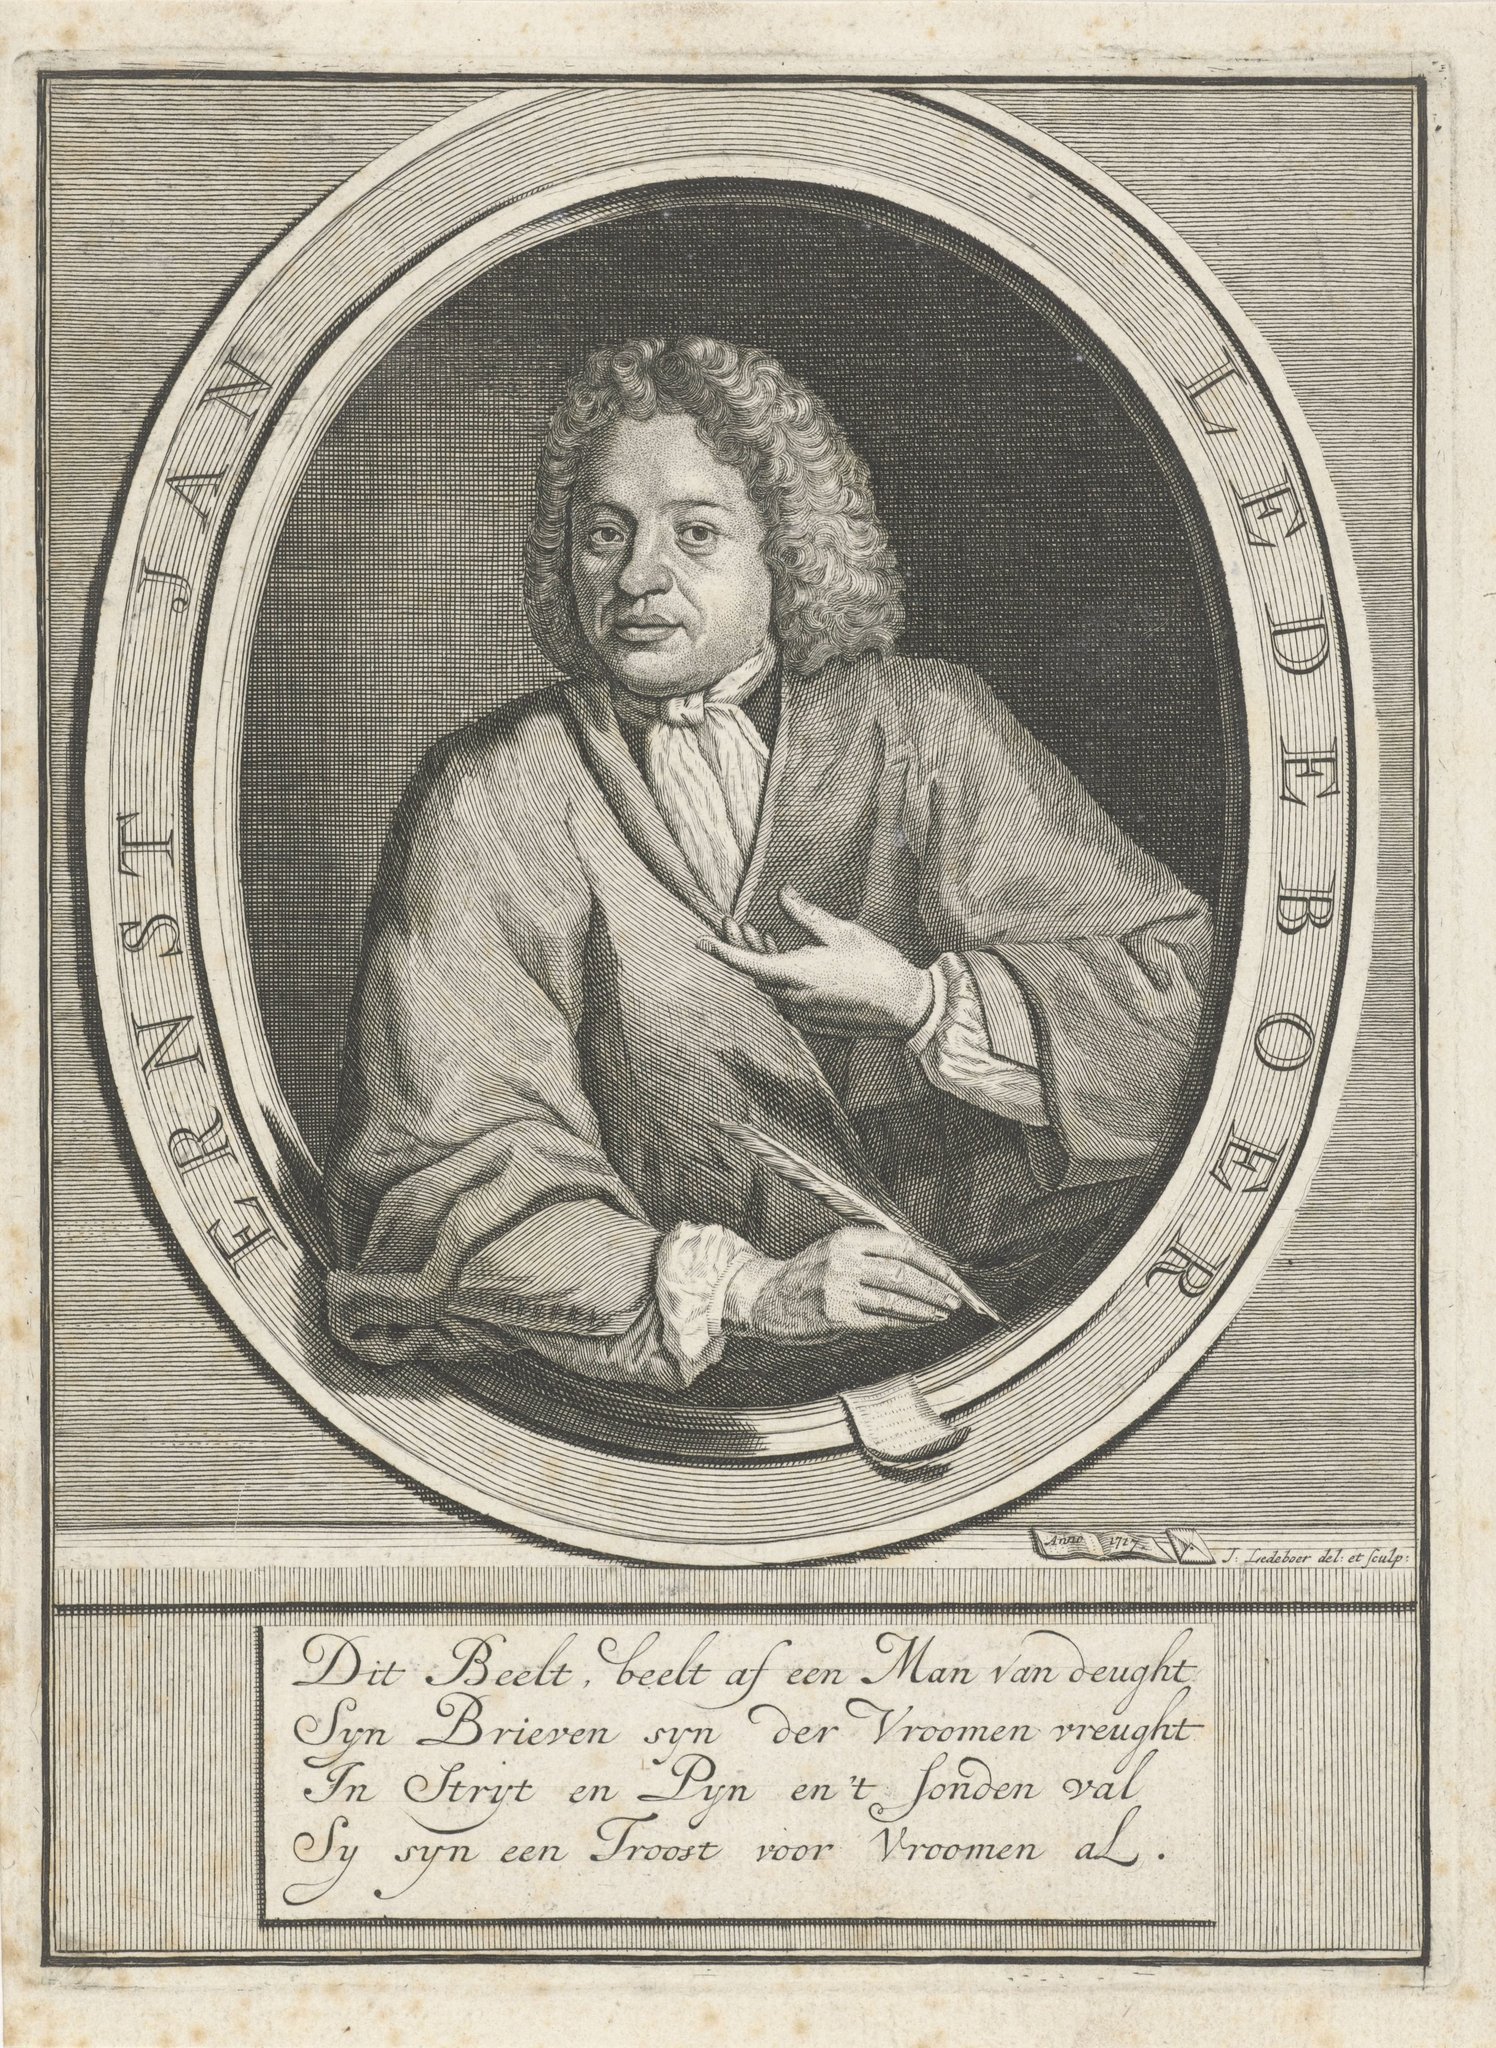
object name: print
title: Portret van Ernst Jan Ledeboer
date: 1717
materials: paper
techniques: engraving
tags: weerselo, schrijver, ernst jan ledeboer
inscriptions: collector's mark: Lugt 2228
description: Portretbuste in ovaal naar rechts van Ernst Jan Ledeboer, godsdienstig schrijver, blootshoofds en met schrijfveer in de hand. Met randschrift en een vierregelig Nederlands vers.